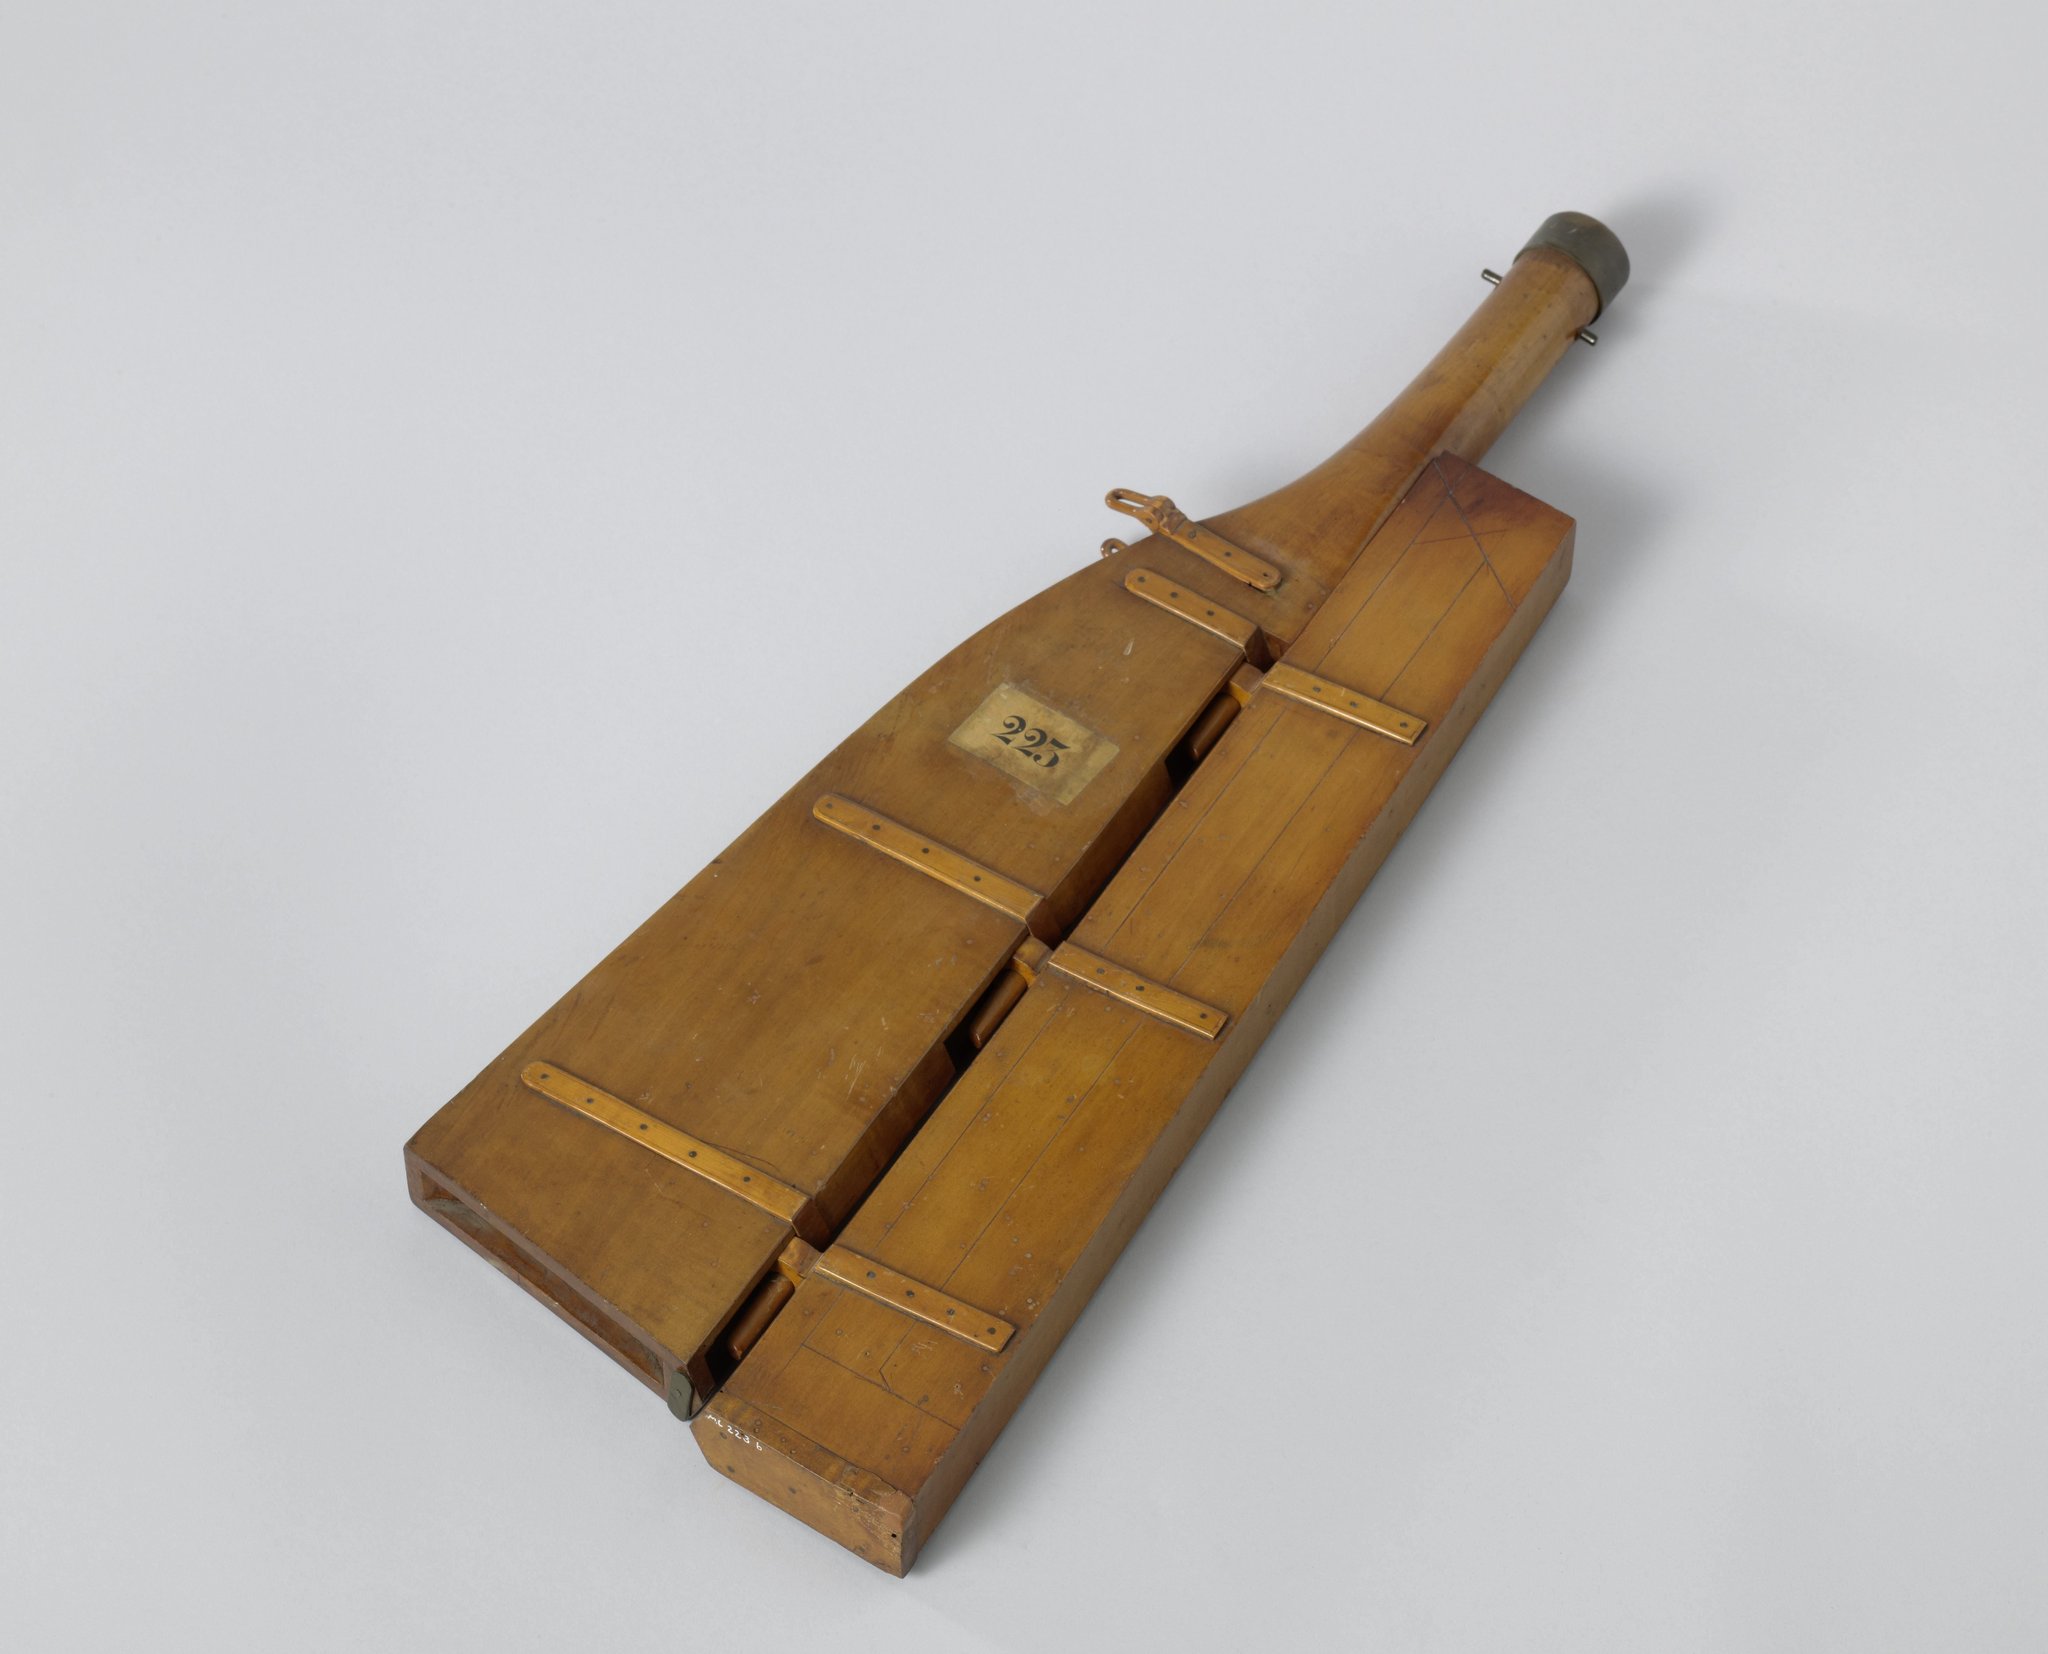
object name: demonstration model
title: Model of a Rudder for Paddle Steamers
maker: Anonymous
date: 1840-1842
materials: brass, wood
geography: netherlands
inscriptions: label, centre: ‘223’ former inventory label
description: Model van een roer en achtersteven. Het roer heeft een ronde roerkoning (Soetermeers versie; zie NG-MC-219, NG-MC-220 en NG-MC-221) en is een stukje korter dan de achtersteven. De kop heeft geen gat voor een roerpen, maar er steekt een korte pin doorheen. Drie houten roerstellen en een houten zorgband met twee ogen. Het roerblad heeft zogklampen achterop en onderop. Onder tegen het roer zit een draaibare lip, die in een opening in de achtersteven draait en het omhoogkomen van het roer belemmert.